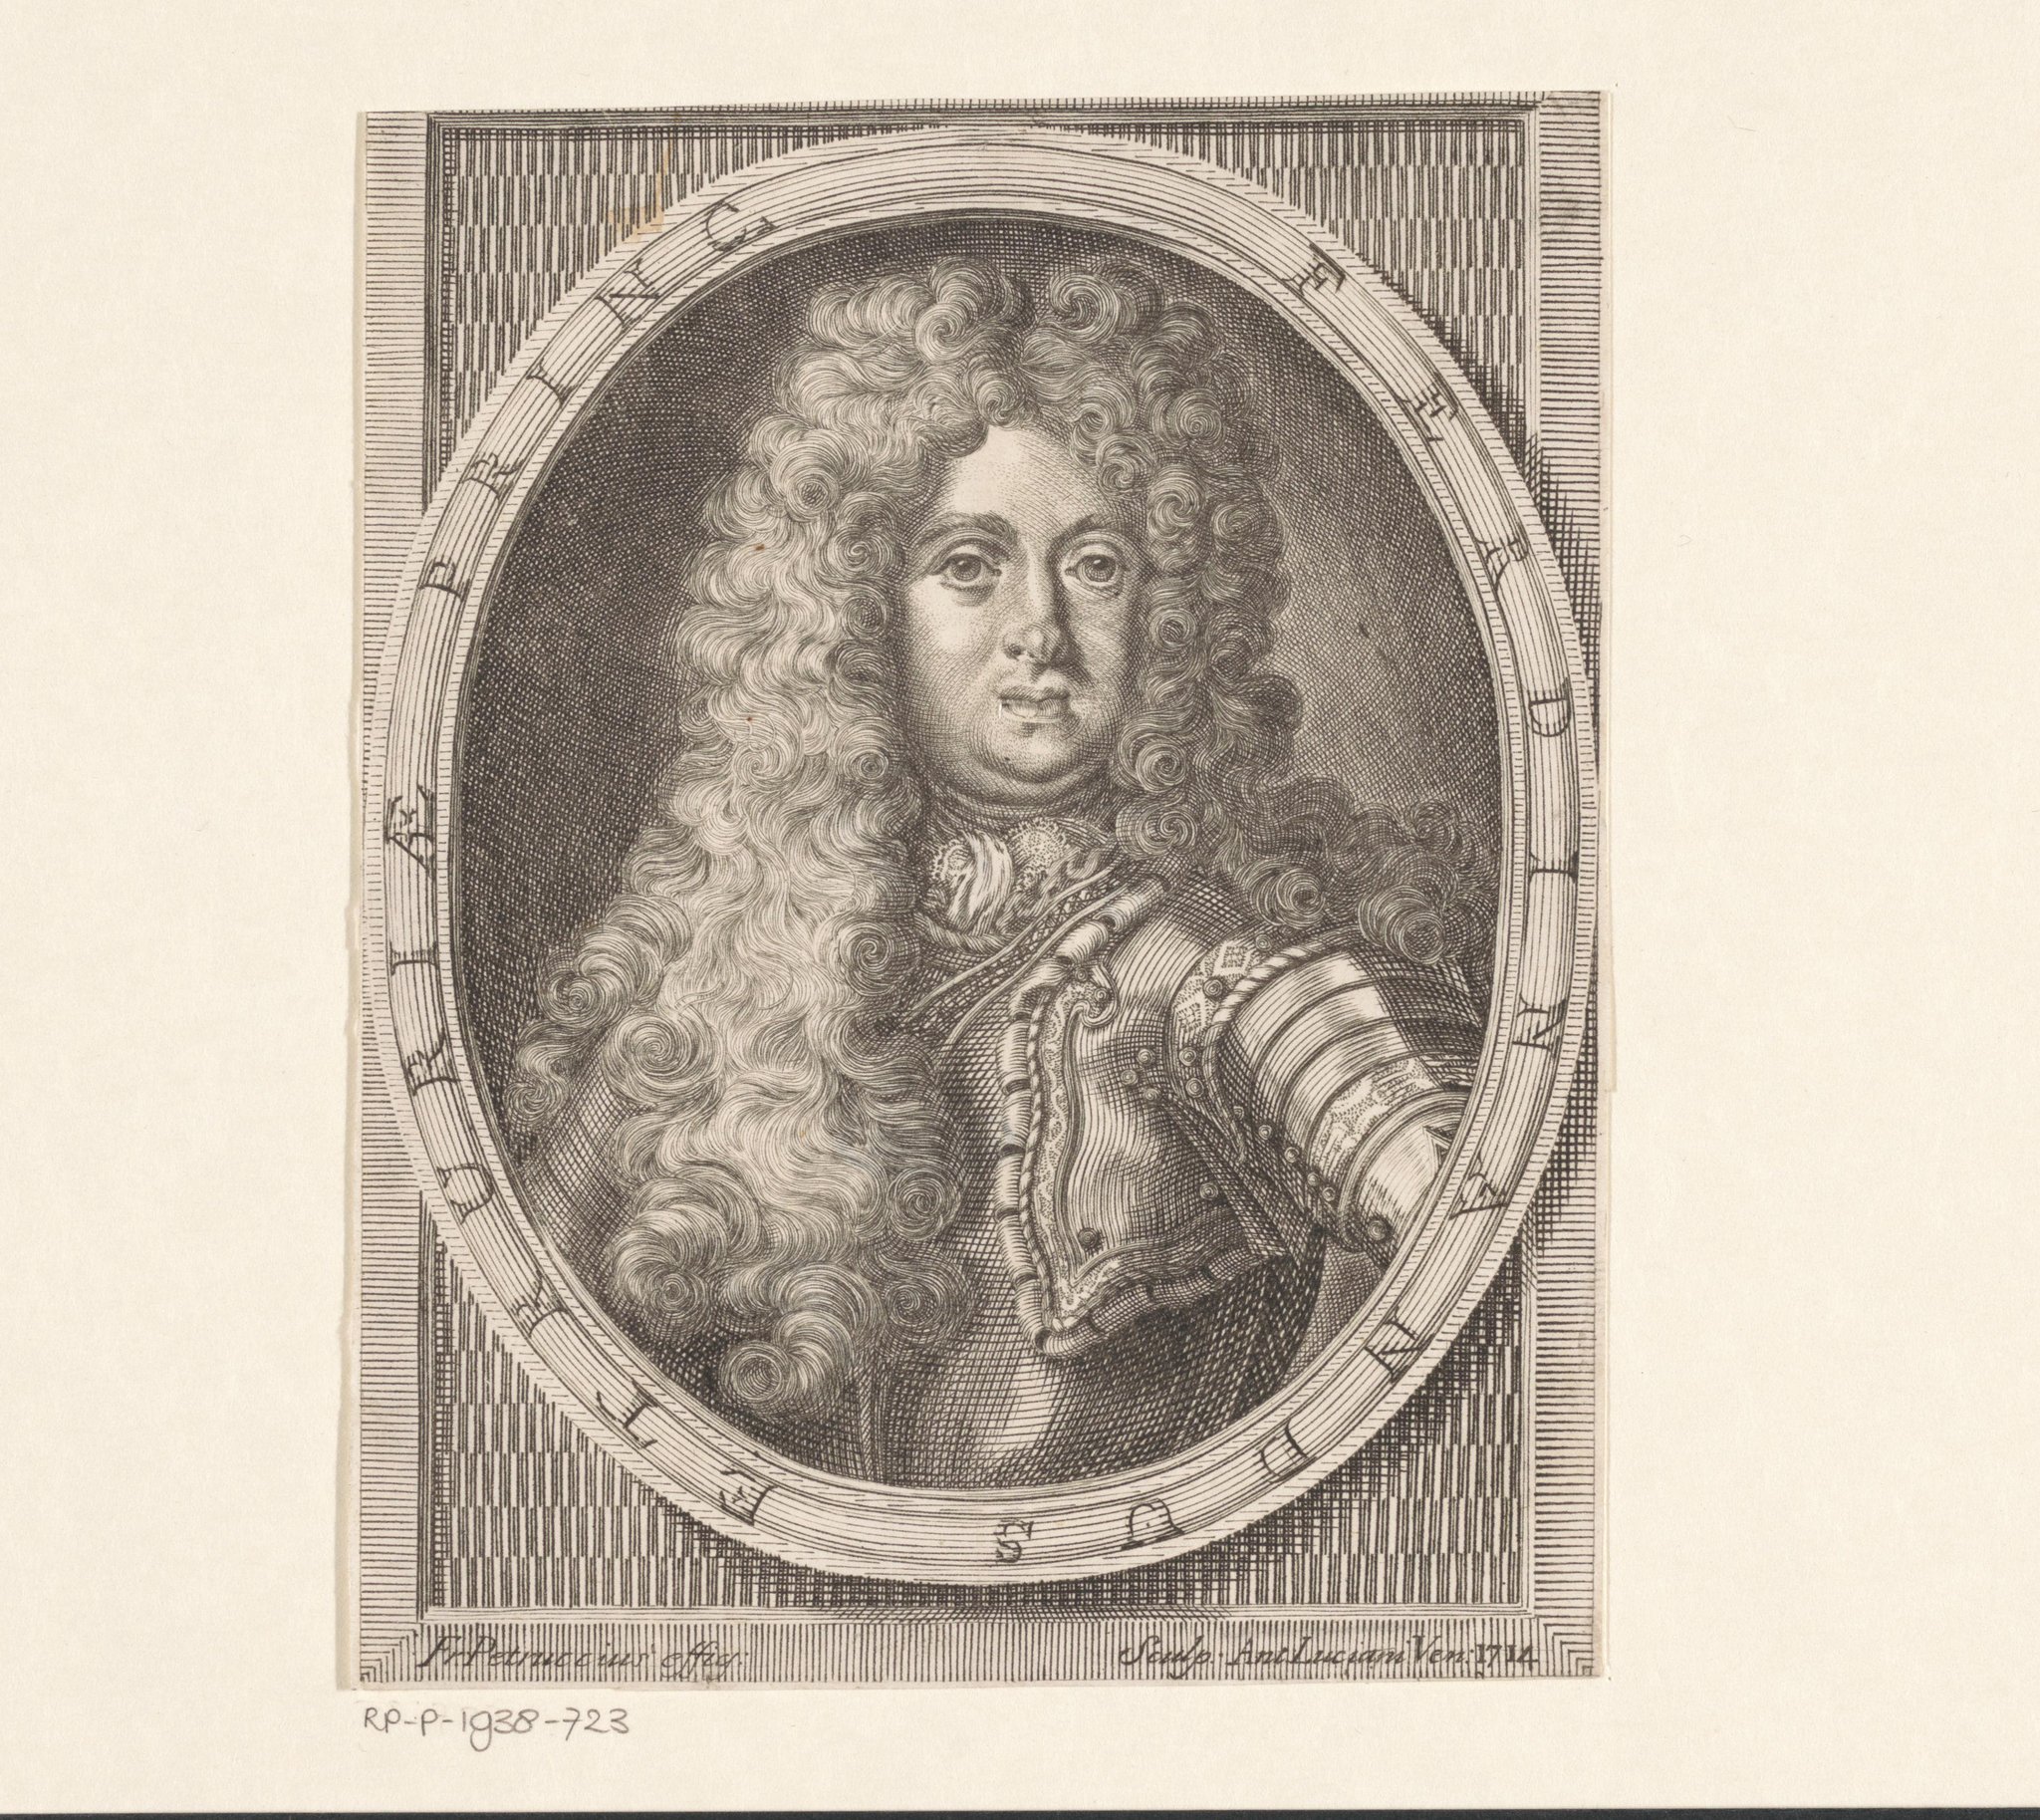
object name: print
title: Portret van Ferdinand, prins van Etrurië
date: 1714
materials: paper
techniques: engraving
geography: venice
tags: historical persons, ruler, sovereign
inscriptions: collector's mark: Lugt 2228